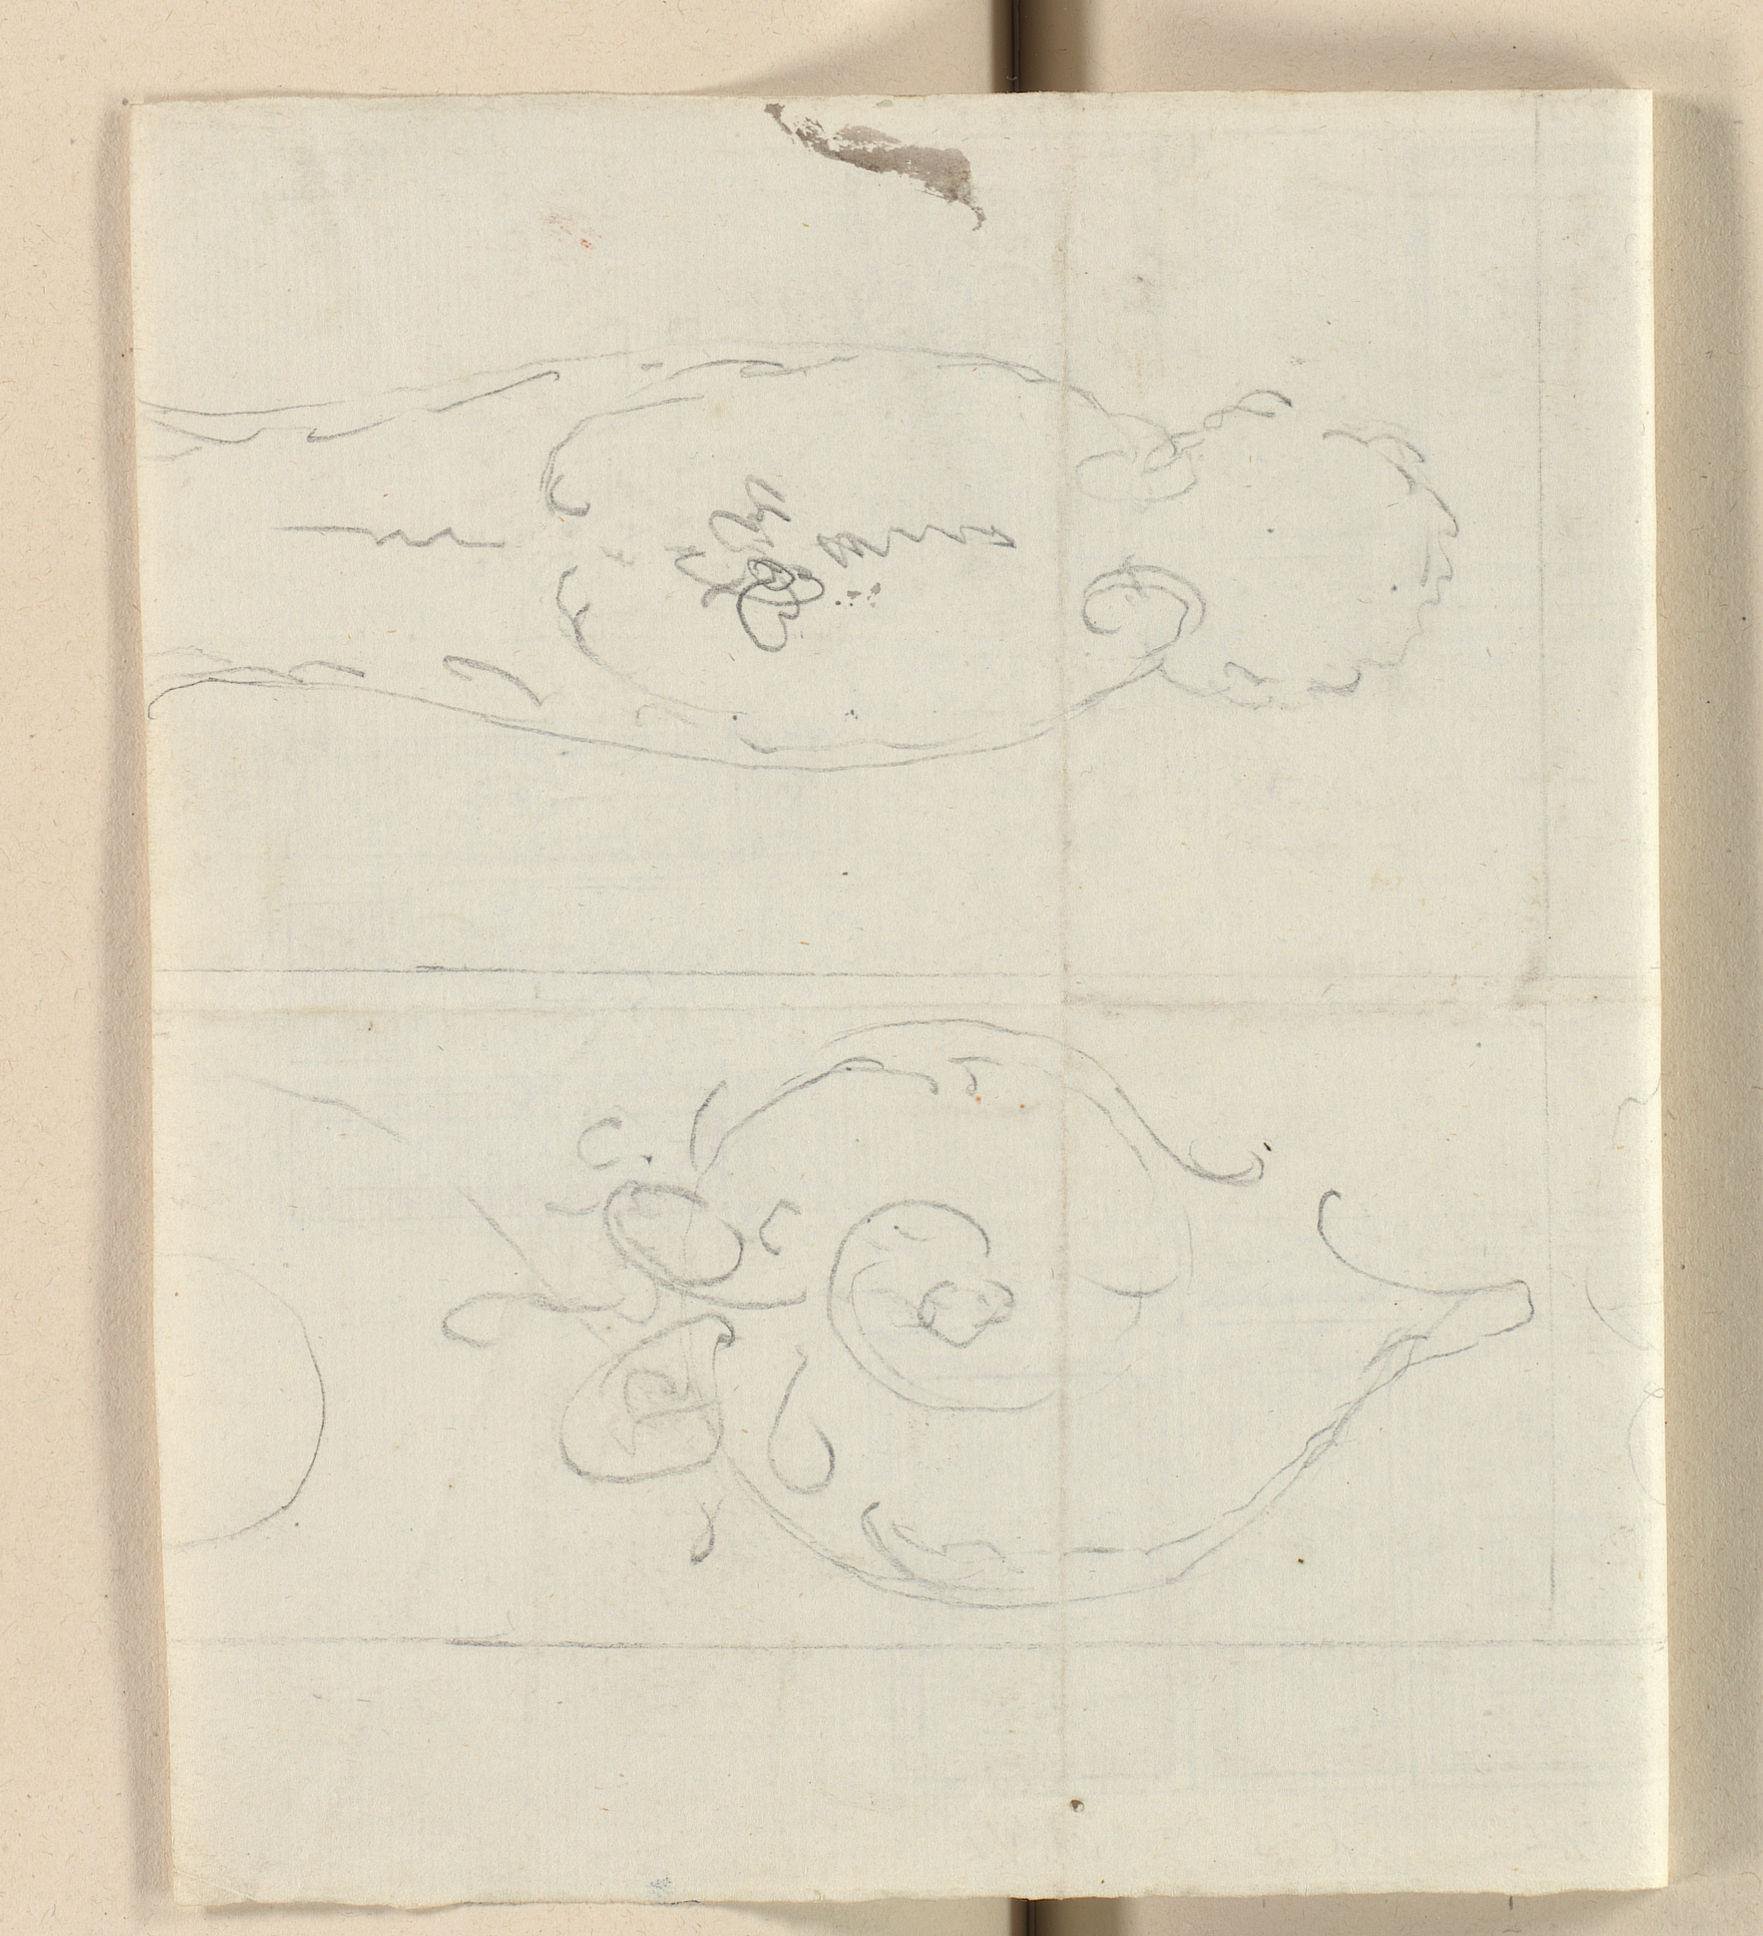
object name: album leaf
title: Ontwerp voor kamerdecoratie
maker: jurriaan andriessen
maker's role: draughtsman, painter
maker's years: 1742-1819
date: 1760-1819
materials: paper, pencil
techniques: pasting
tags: decorations (interior of the house)